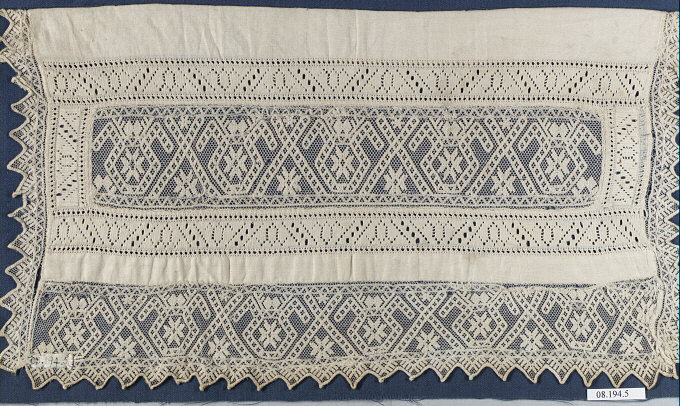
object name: cap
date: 1801-1900